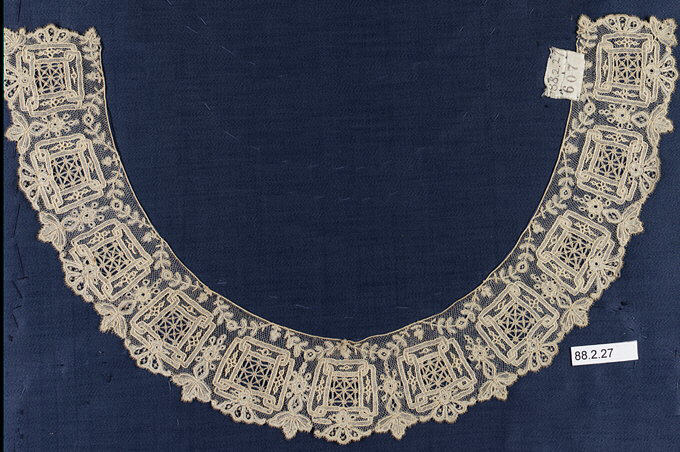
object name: collar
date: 1851-1875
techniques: lace